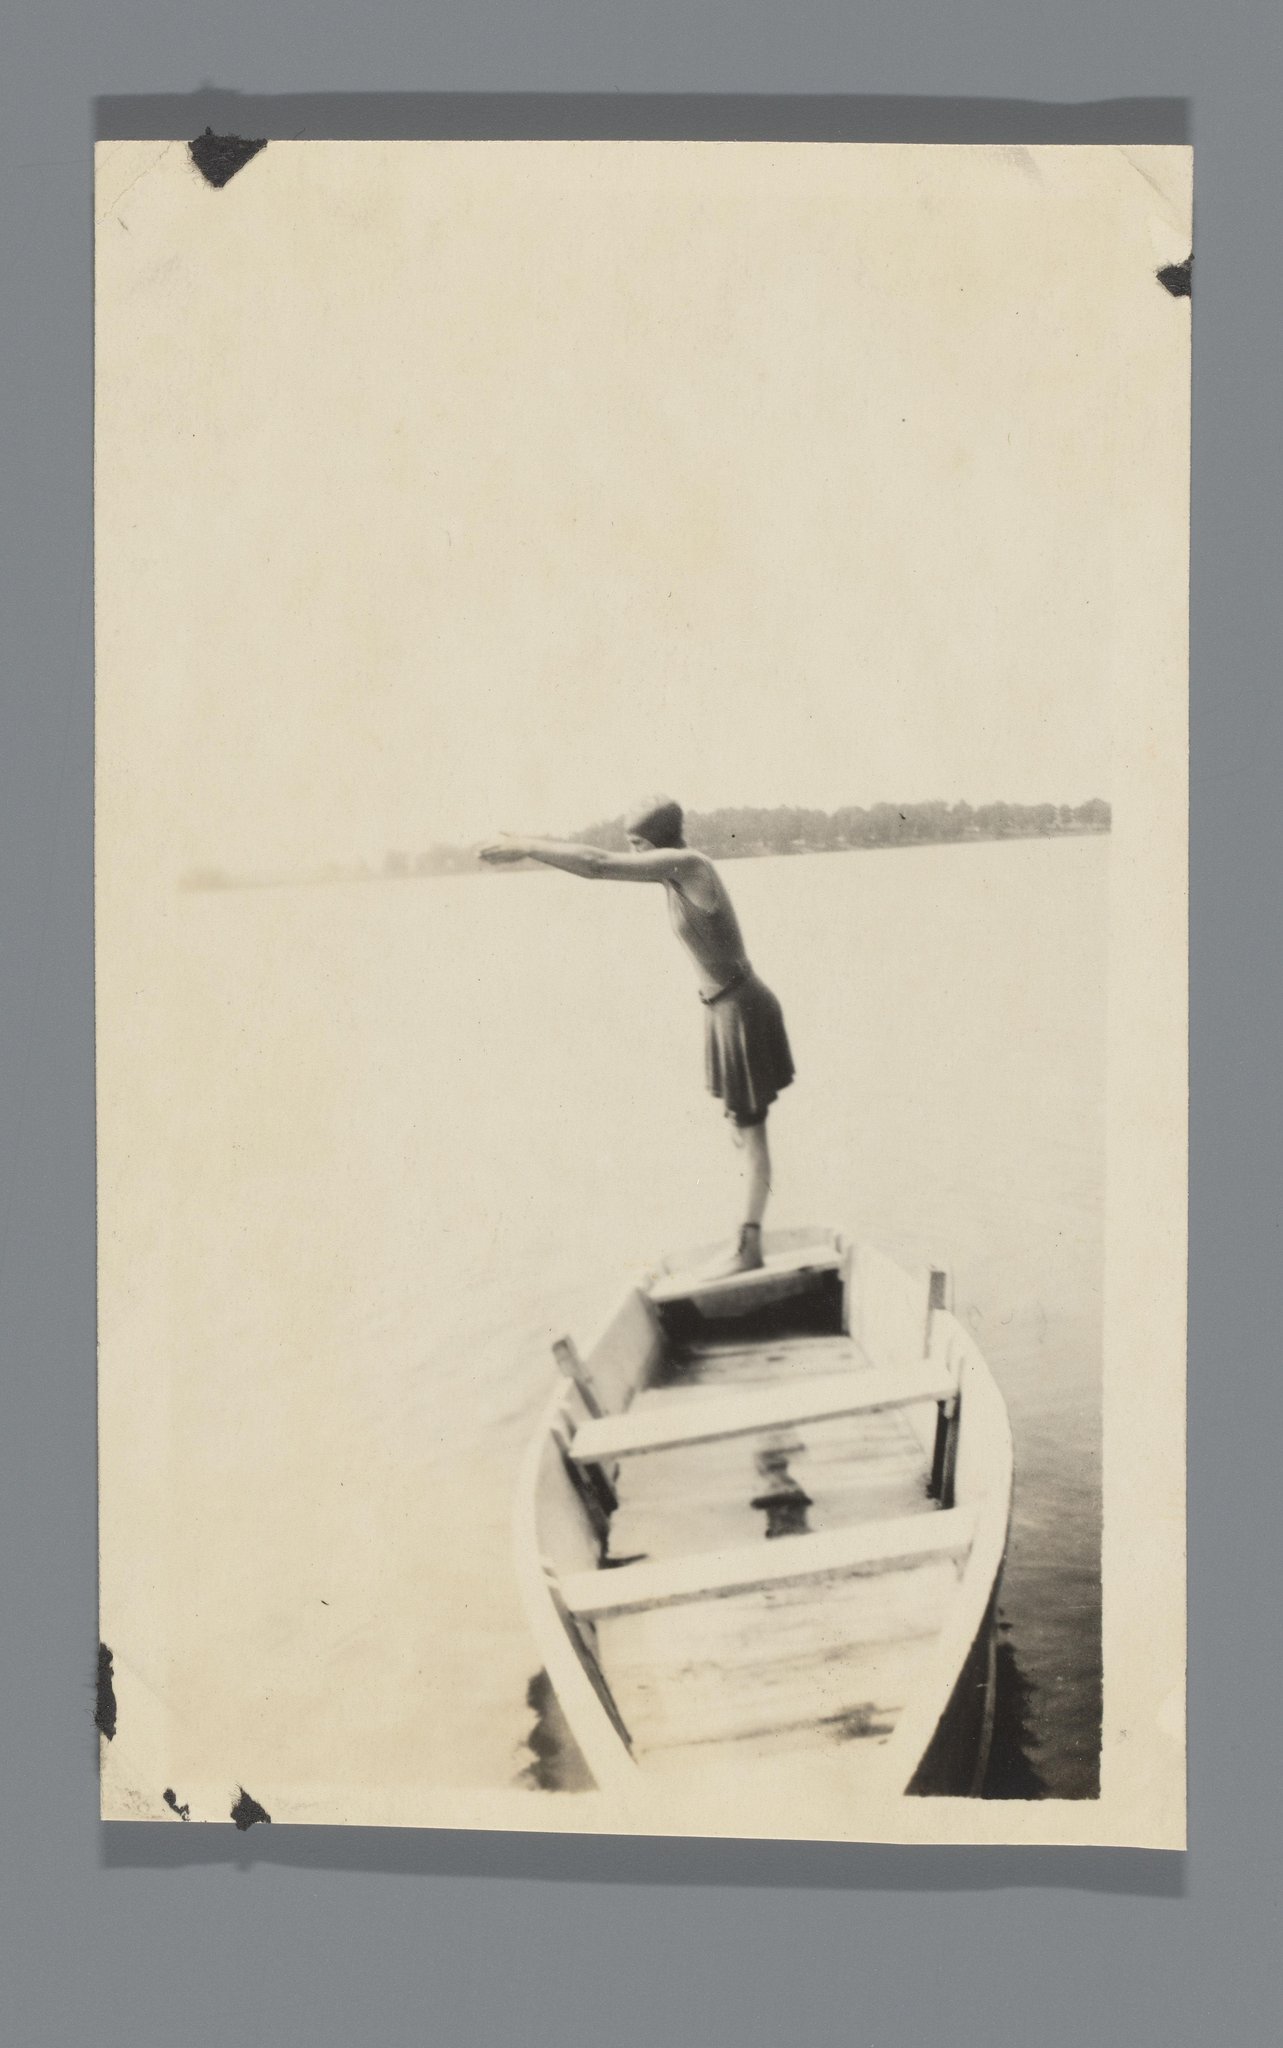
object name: photograph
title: Snapshot van een vrouw op een roeiboot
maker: Anonymous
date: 1925-1940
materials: photographic support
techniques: gelatin silver print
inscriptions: inscription: ‘C’